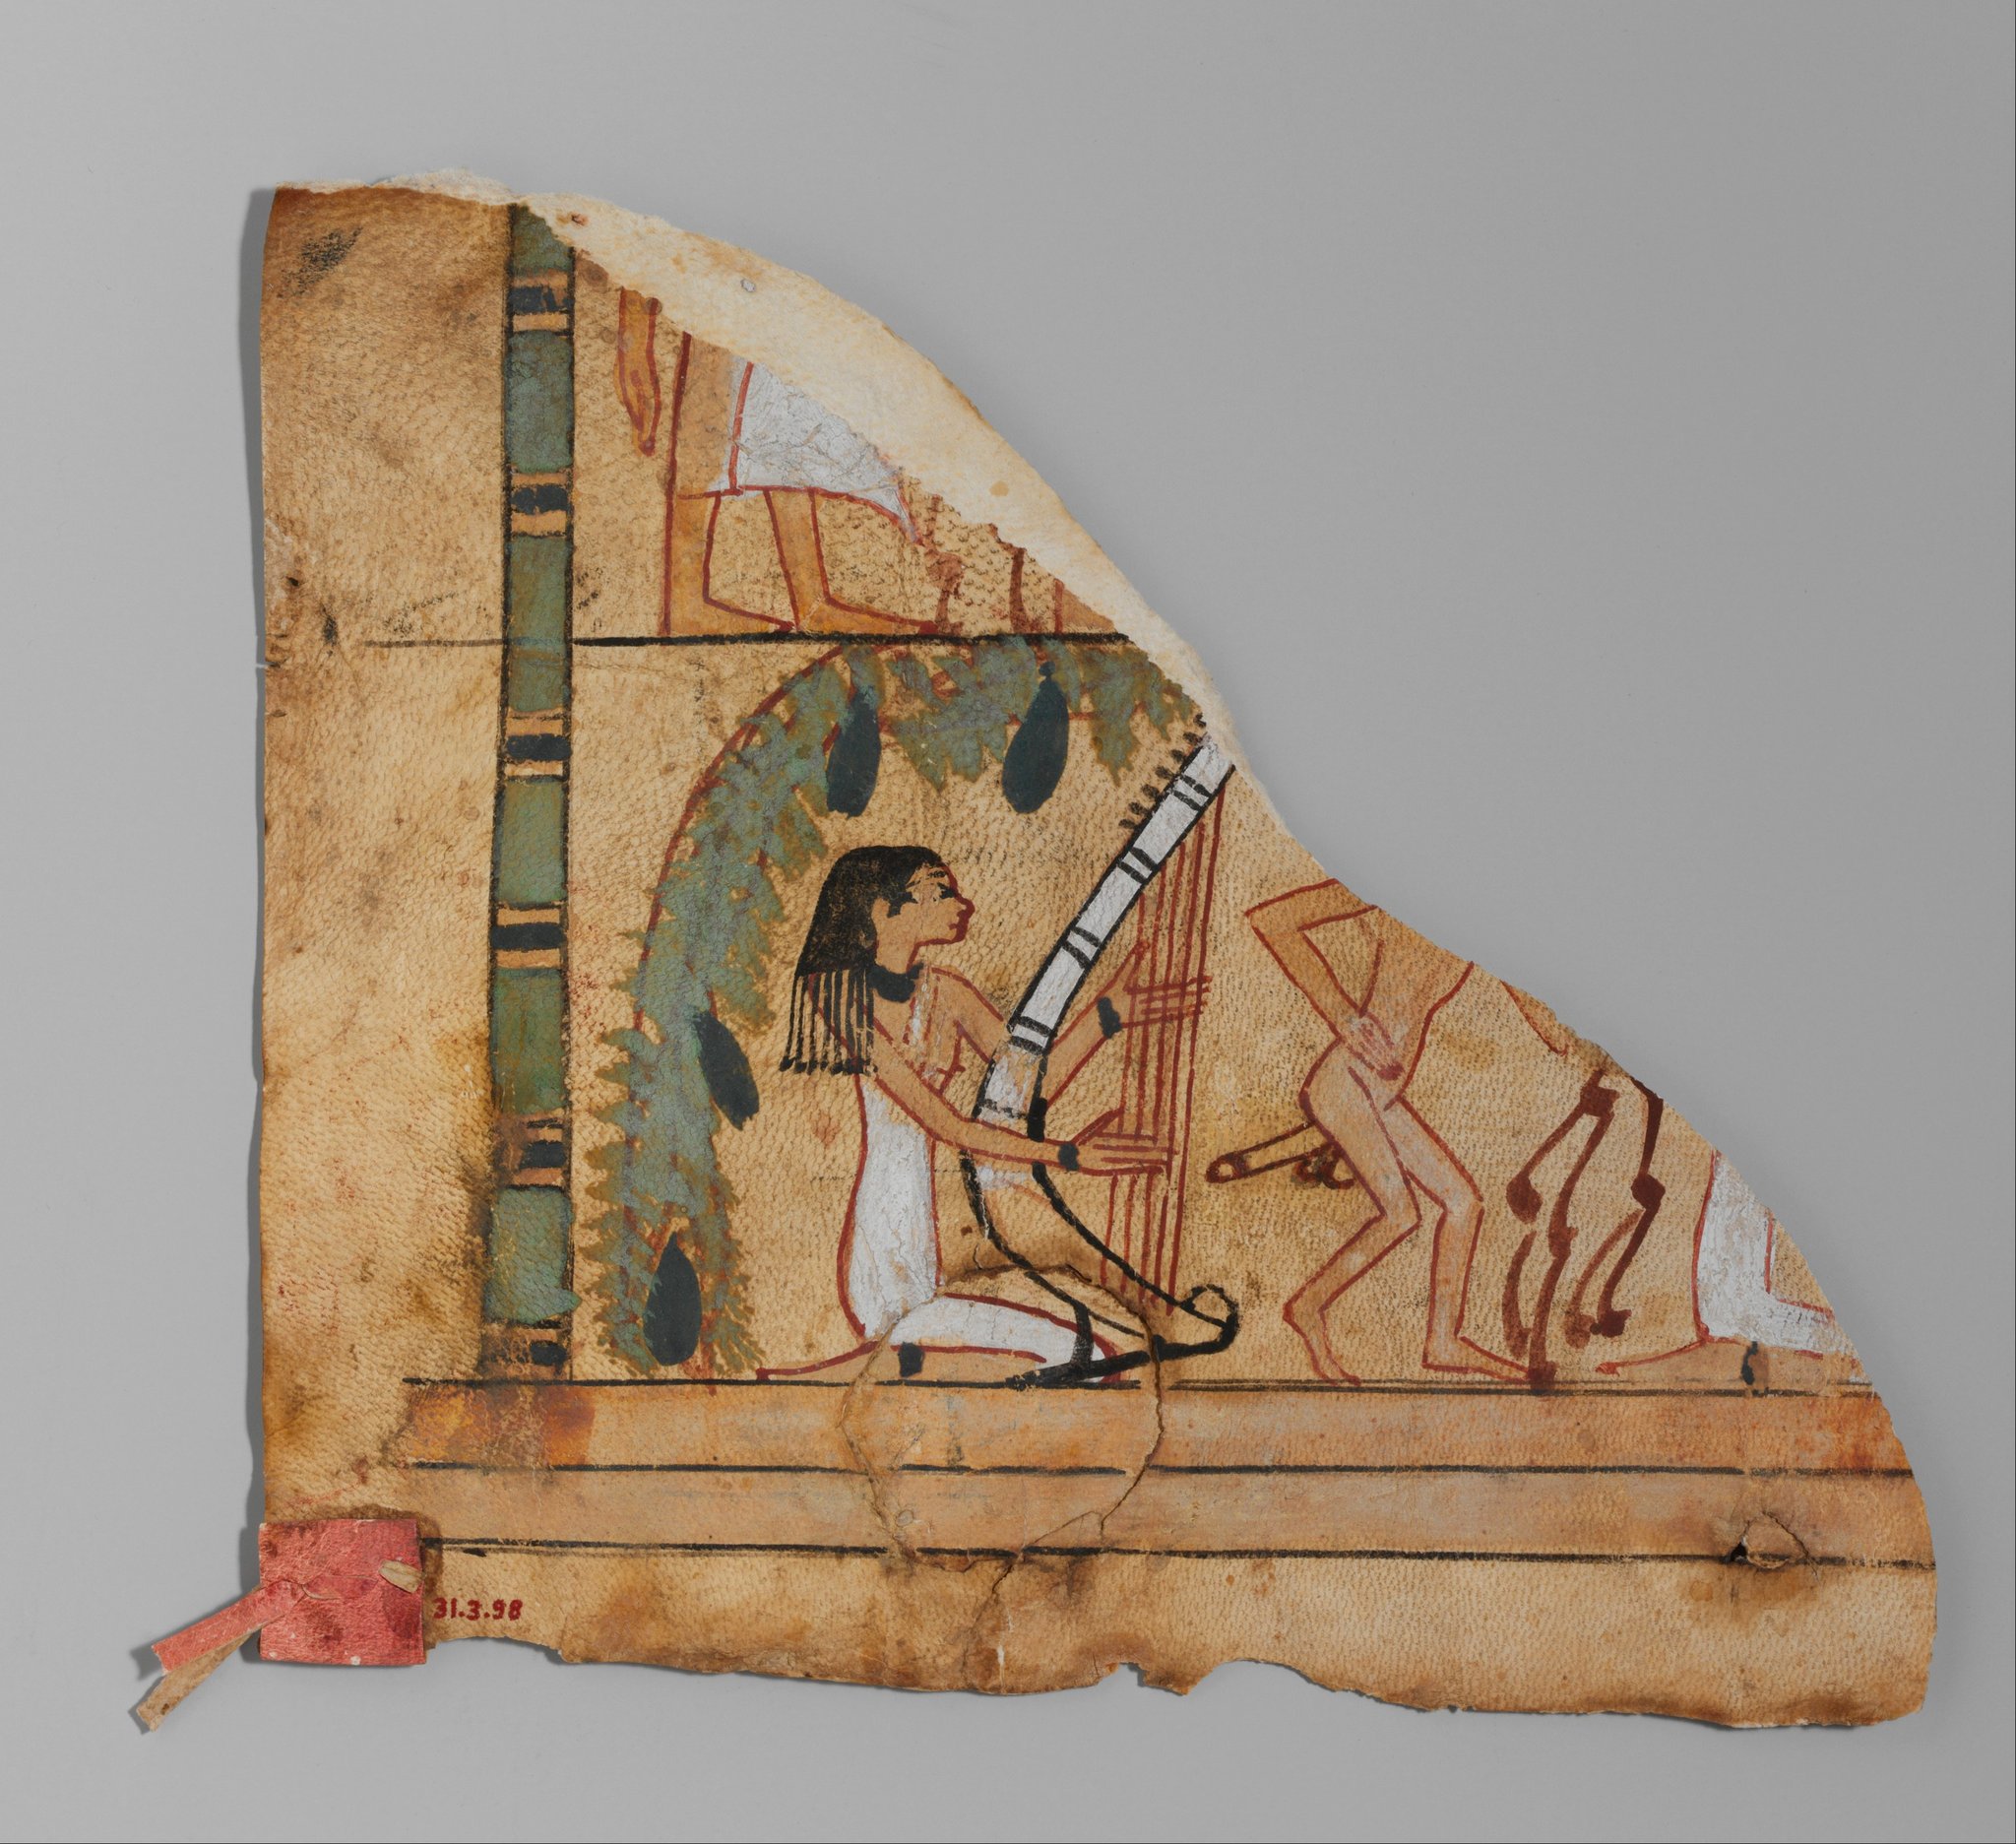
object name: painting, erotic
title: Fragment of a Leather Hanging(?) with an Erotic Scene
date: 1550-1458 BCE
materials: leather, paint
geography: egypt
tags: male nudes,women,harps,musicians